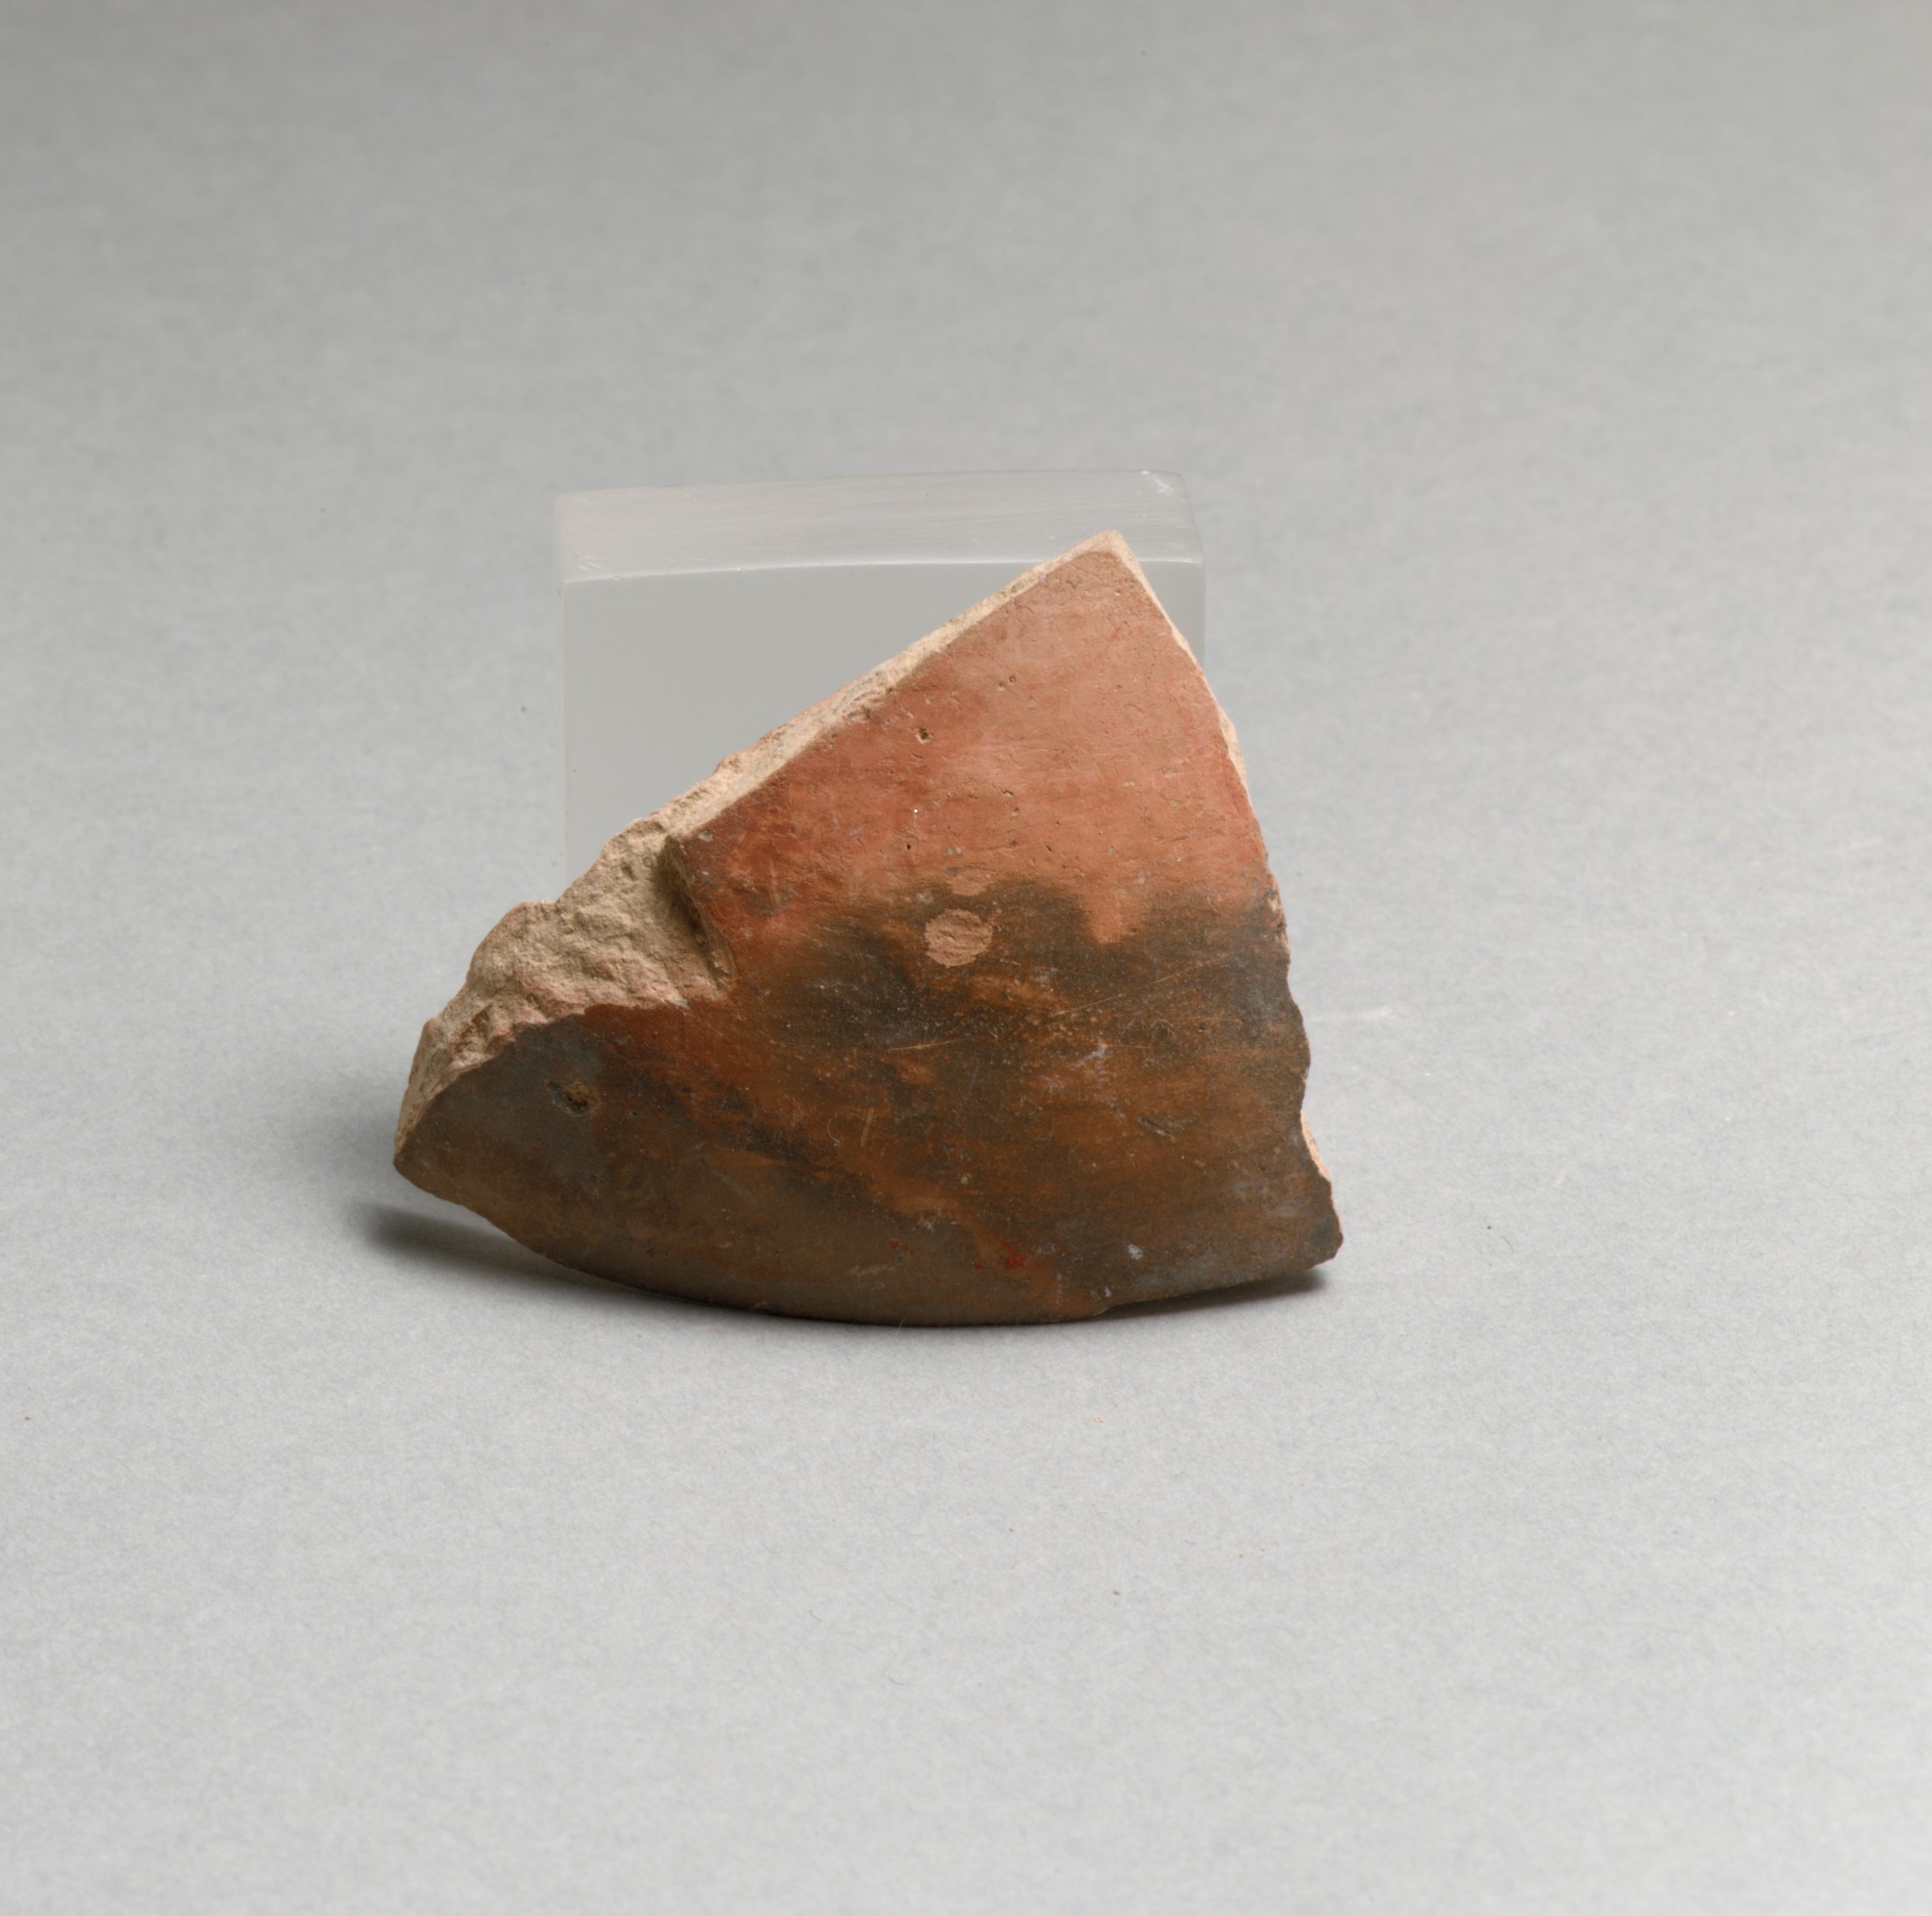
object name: vase fragment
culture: minoan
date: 2600-2000 BCE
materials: terracotta